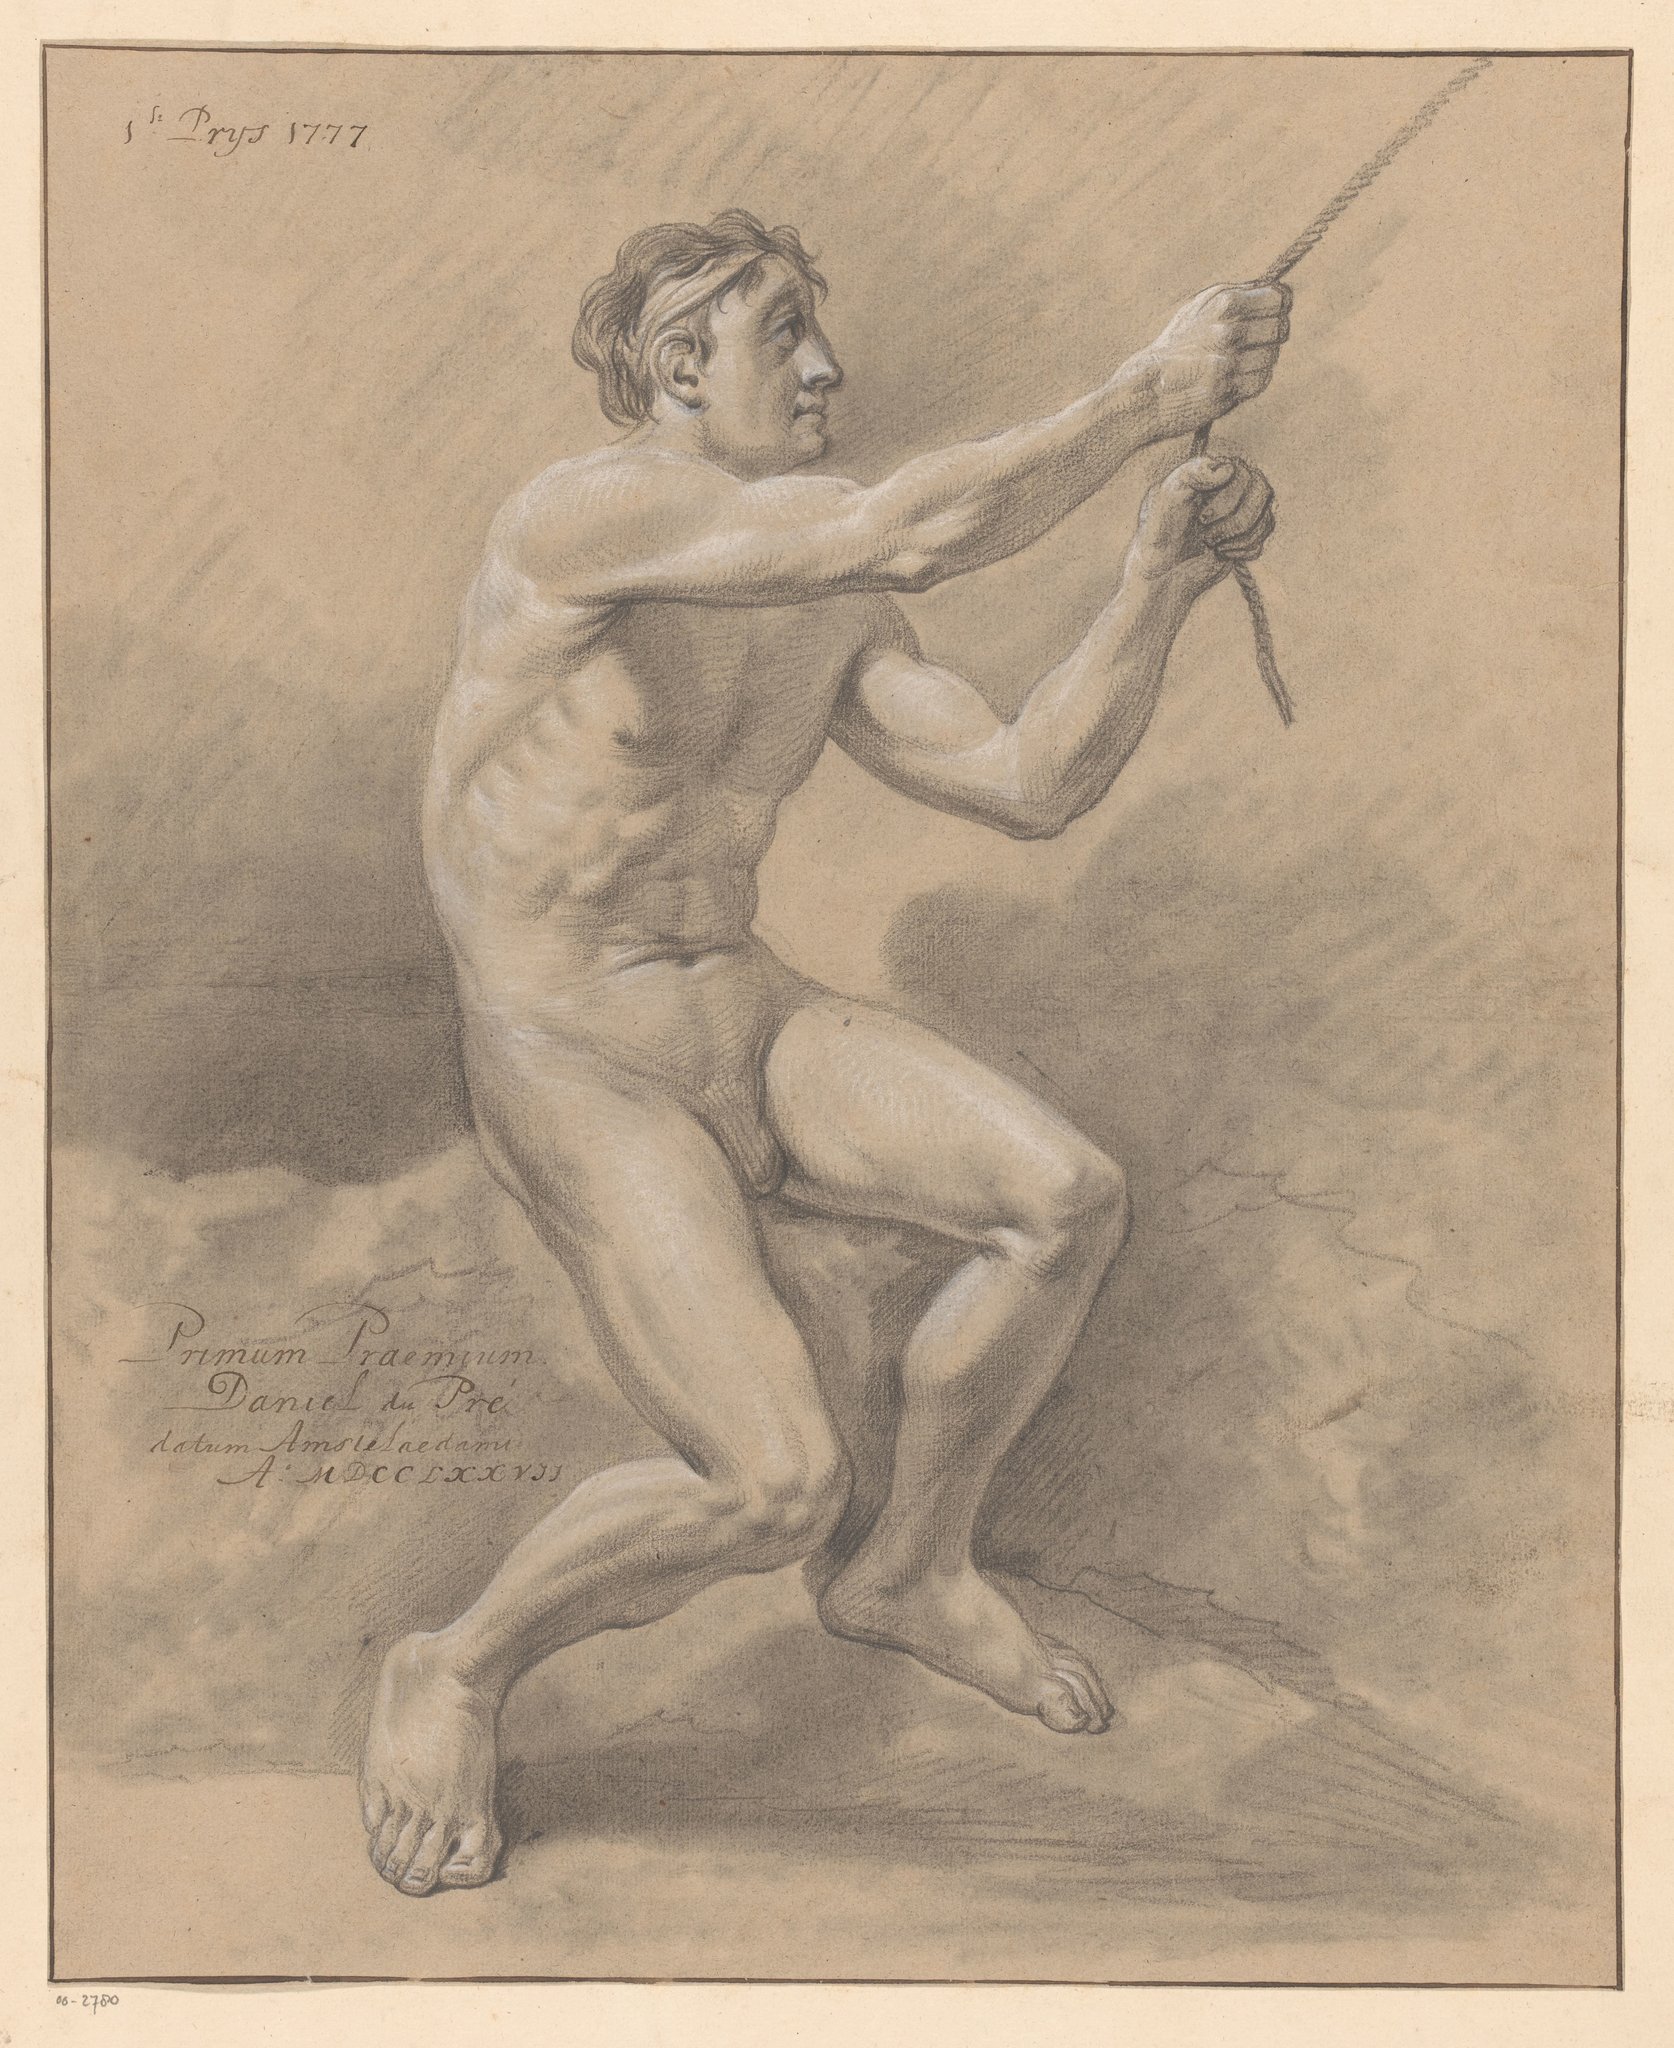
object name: drawing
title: Zittend mannelijk naakt, van opzij gezien (1e prijs 1777)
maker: daniël dupré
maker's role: draughtsman, print maker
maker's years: 1751-1817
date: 1777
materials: chalk, paper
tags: sitting figure (+ nude human being)